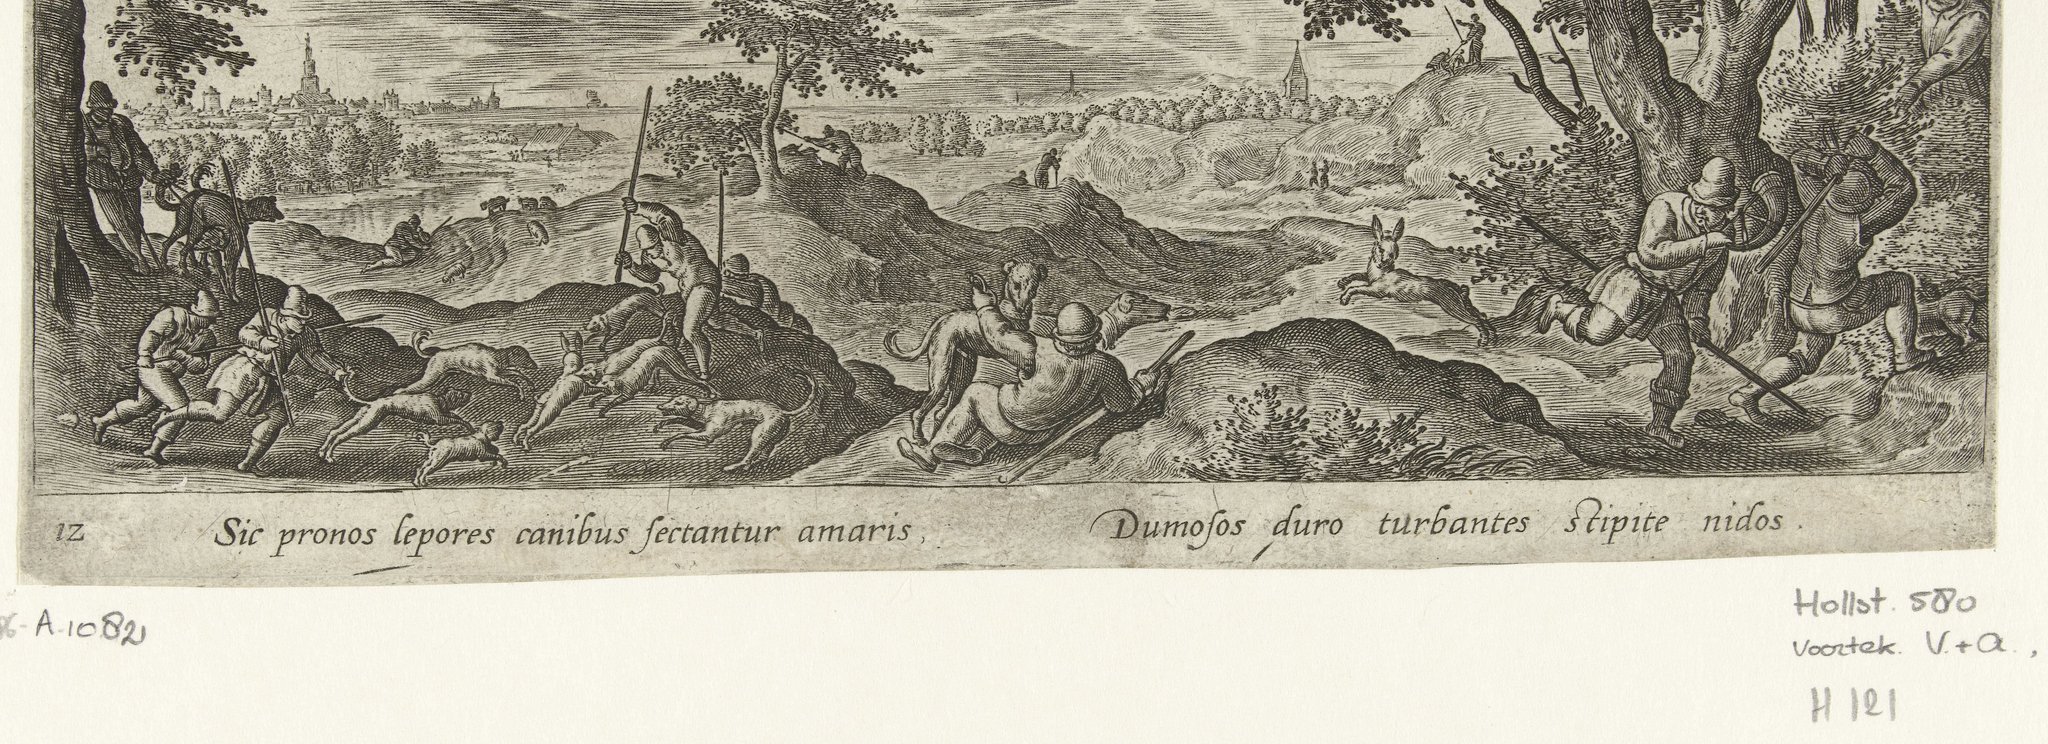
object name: print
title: Hazenjacht met drijvers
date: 1582-1633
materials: paper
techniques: engraving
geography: antwerp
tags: rodents: hare, hare-hunting, rabbit-hunting (+ hunting with dogs)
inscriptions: collector's mark: Lugt 2228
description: Drijvers jagen hazen uit hun schuilplaatsen in het struikgewas. De hazen worden vervolgens opgejaagd door honden en met speren doorgemaakt. De prent heeft een Latijns onderschrift en maakt deel uit van een serie van 54 prenten.